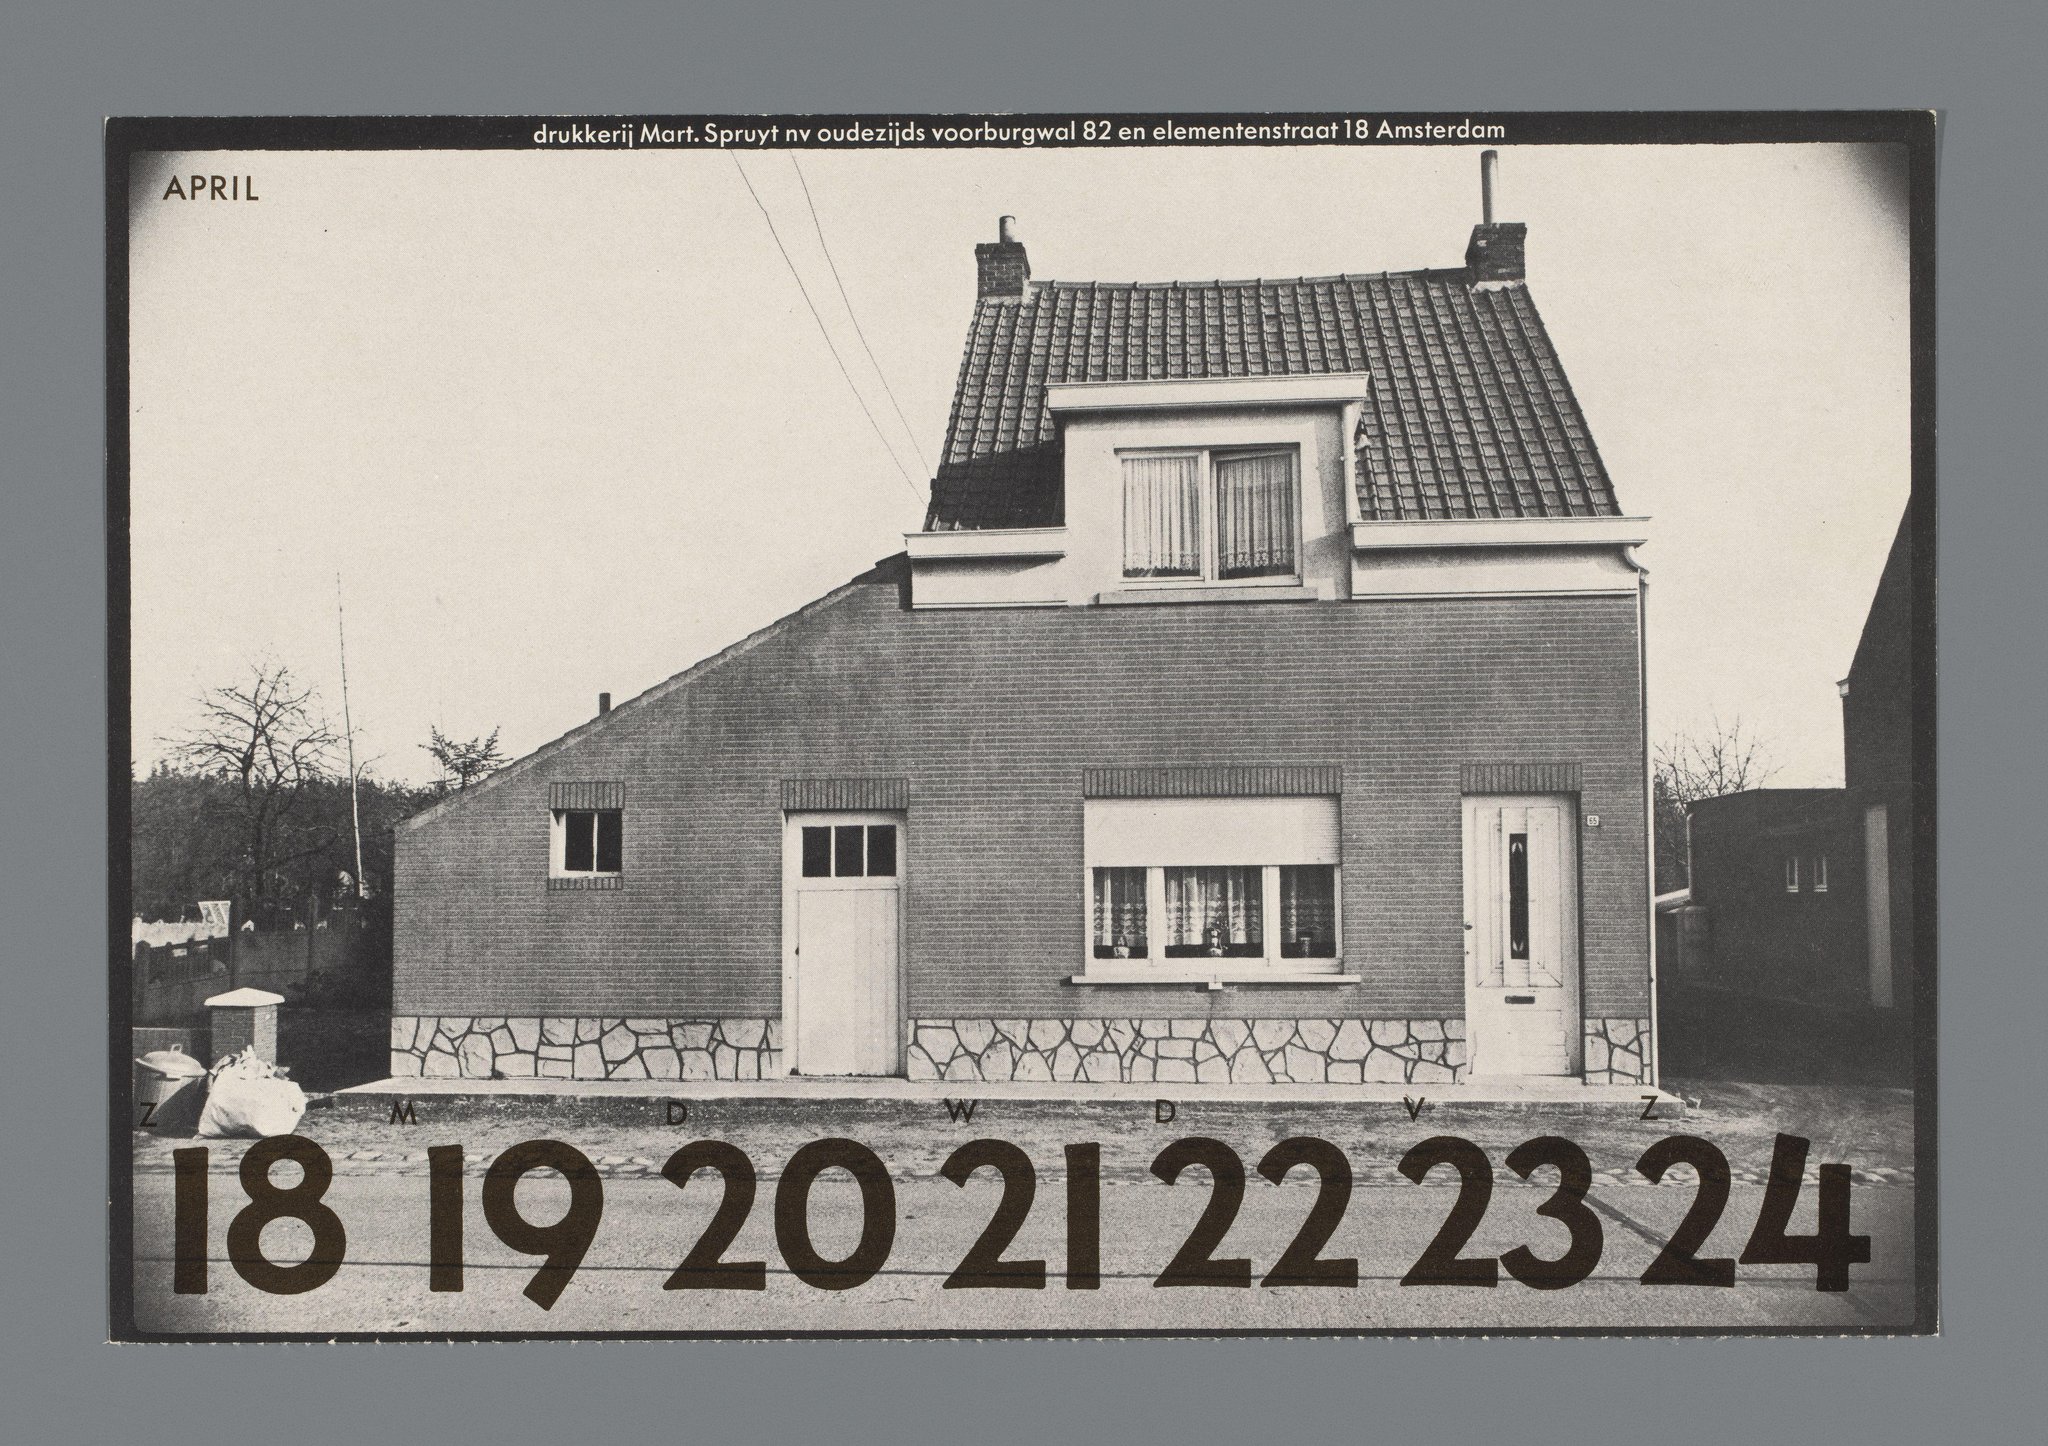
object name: photograph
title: België. Huizen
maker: Anonymous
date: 1900-1950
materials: paper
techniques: offset printed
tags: belgium